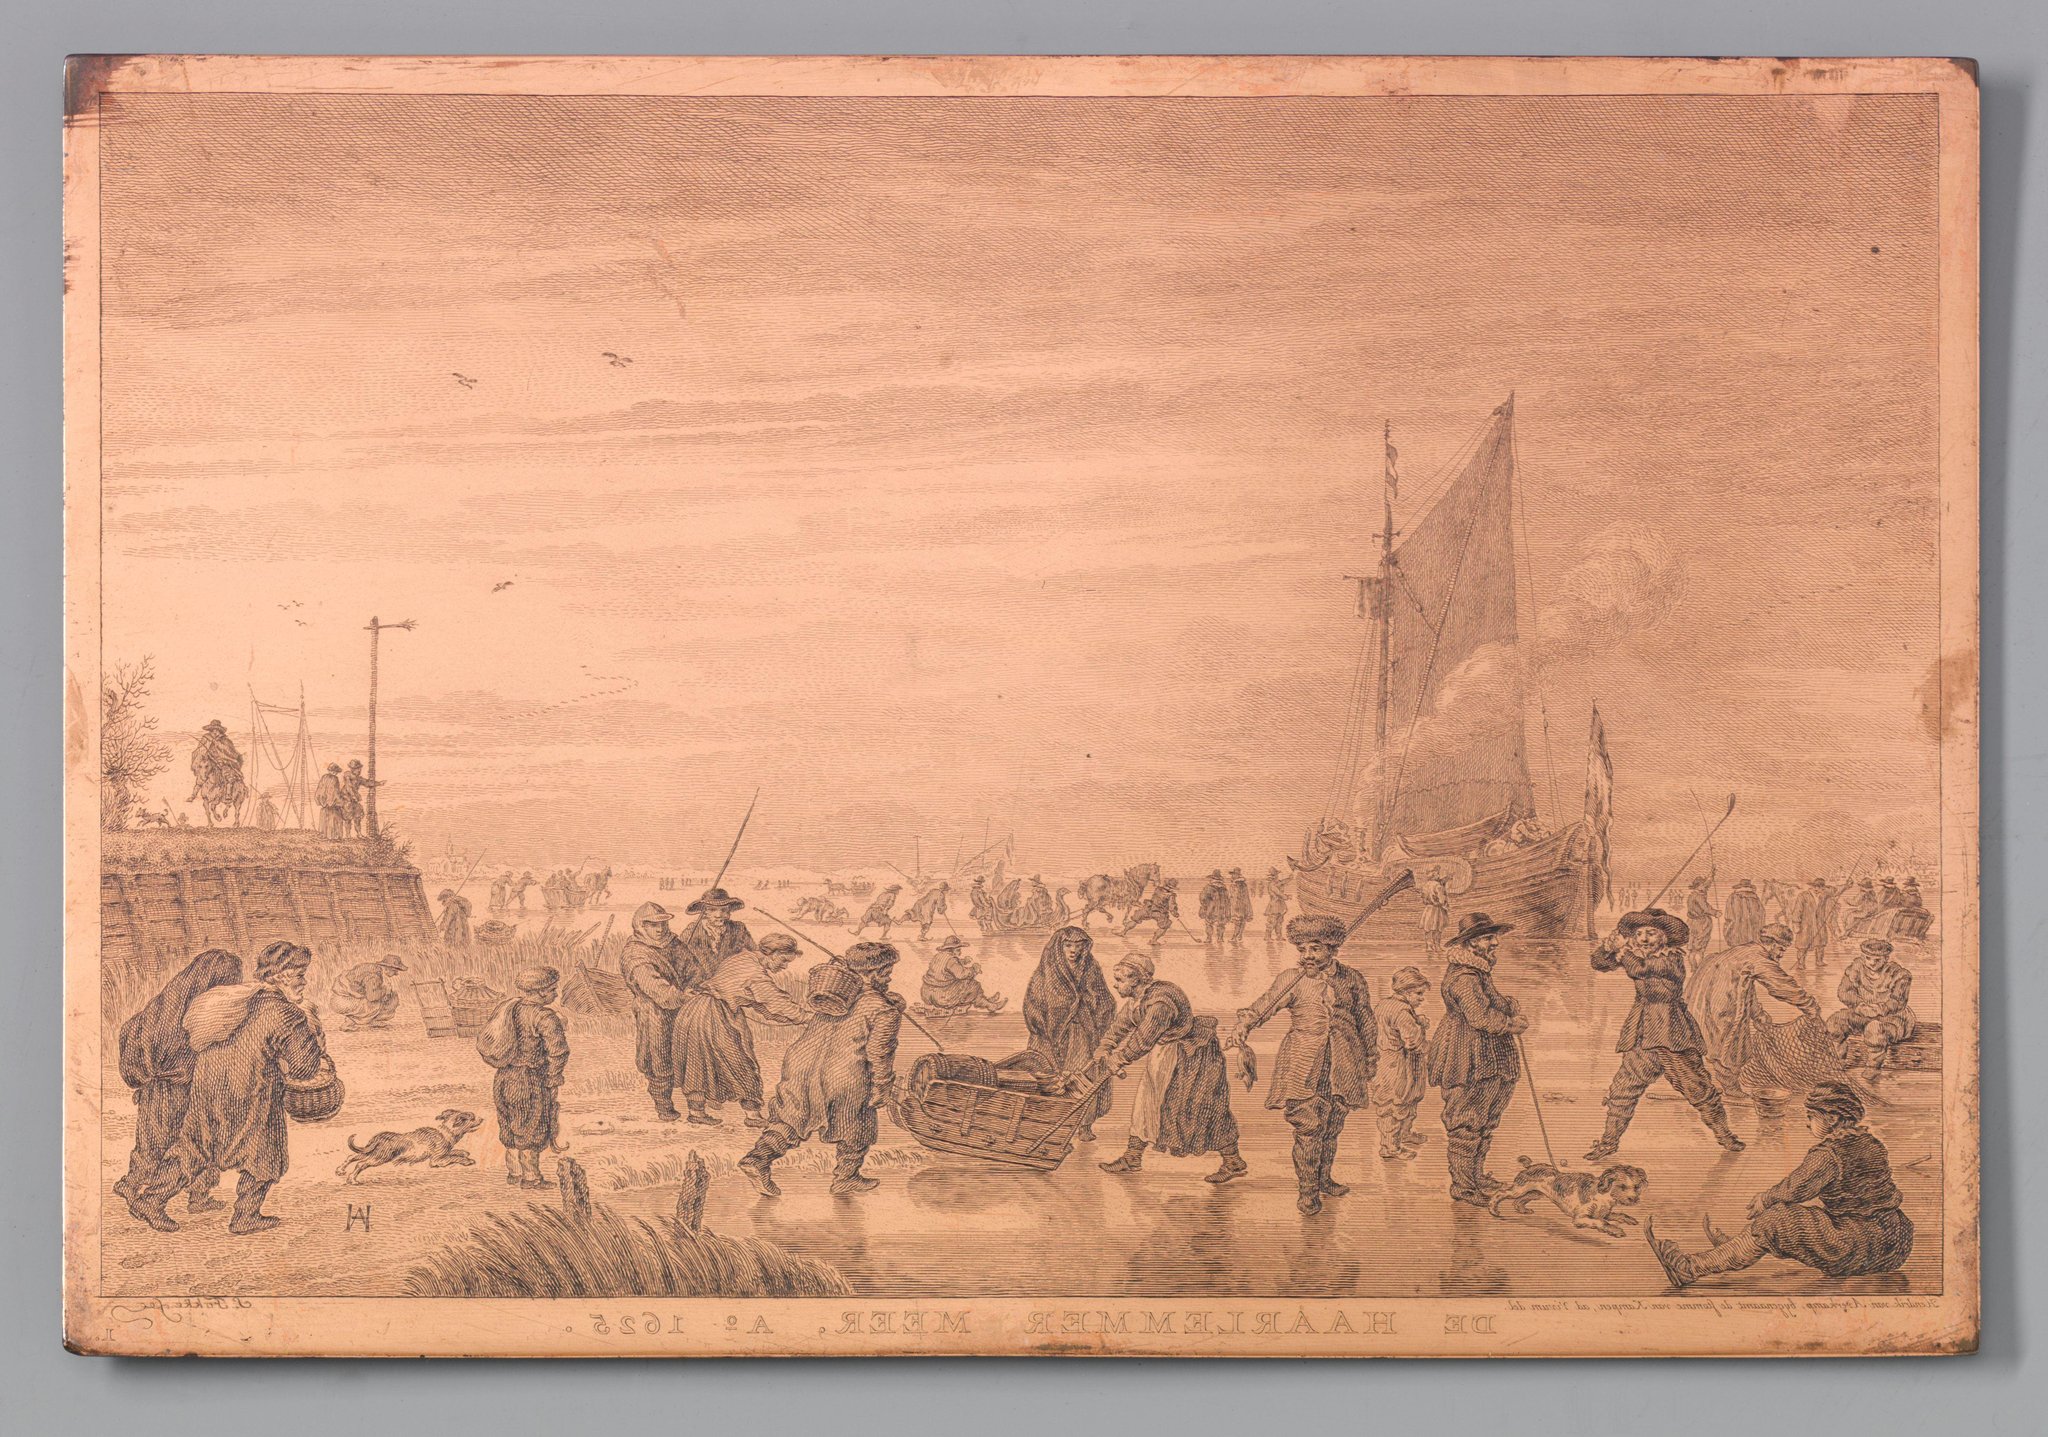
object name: copper plate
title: De Haarlemmermeer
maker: simon fokke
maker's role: draughtsman, print maker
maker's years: 1712-1784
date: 1722-1784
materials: copper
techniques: etching